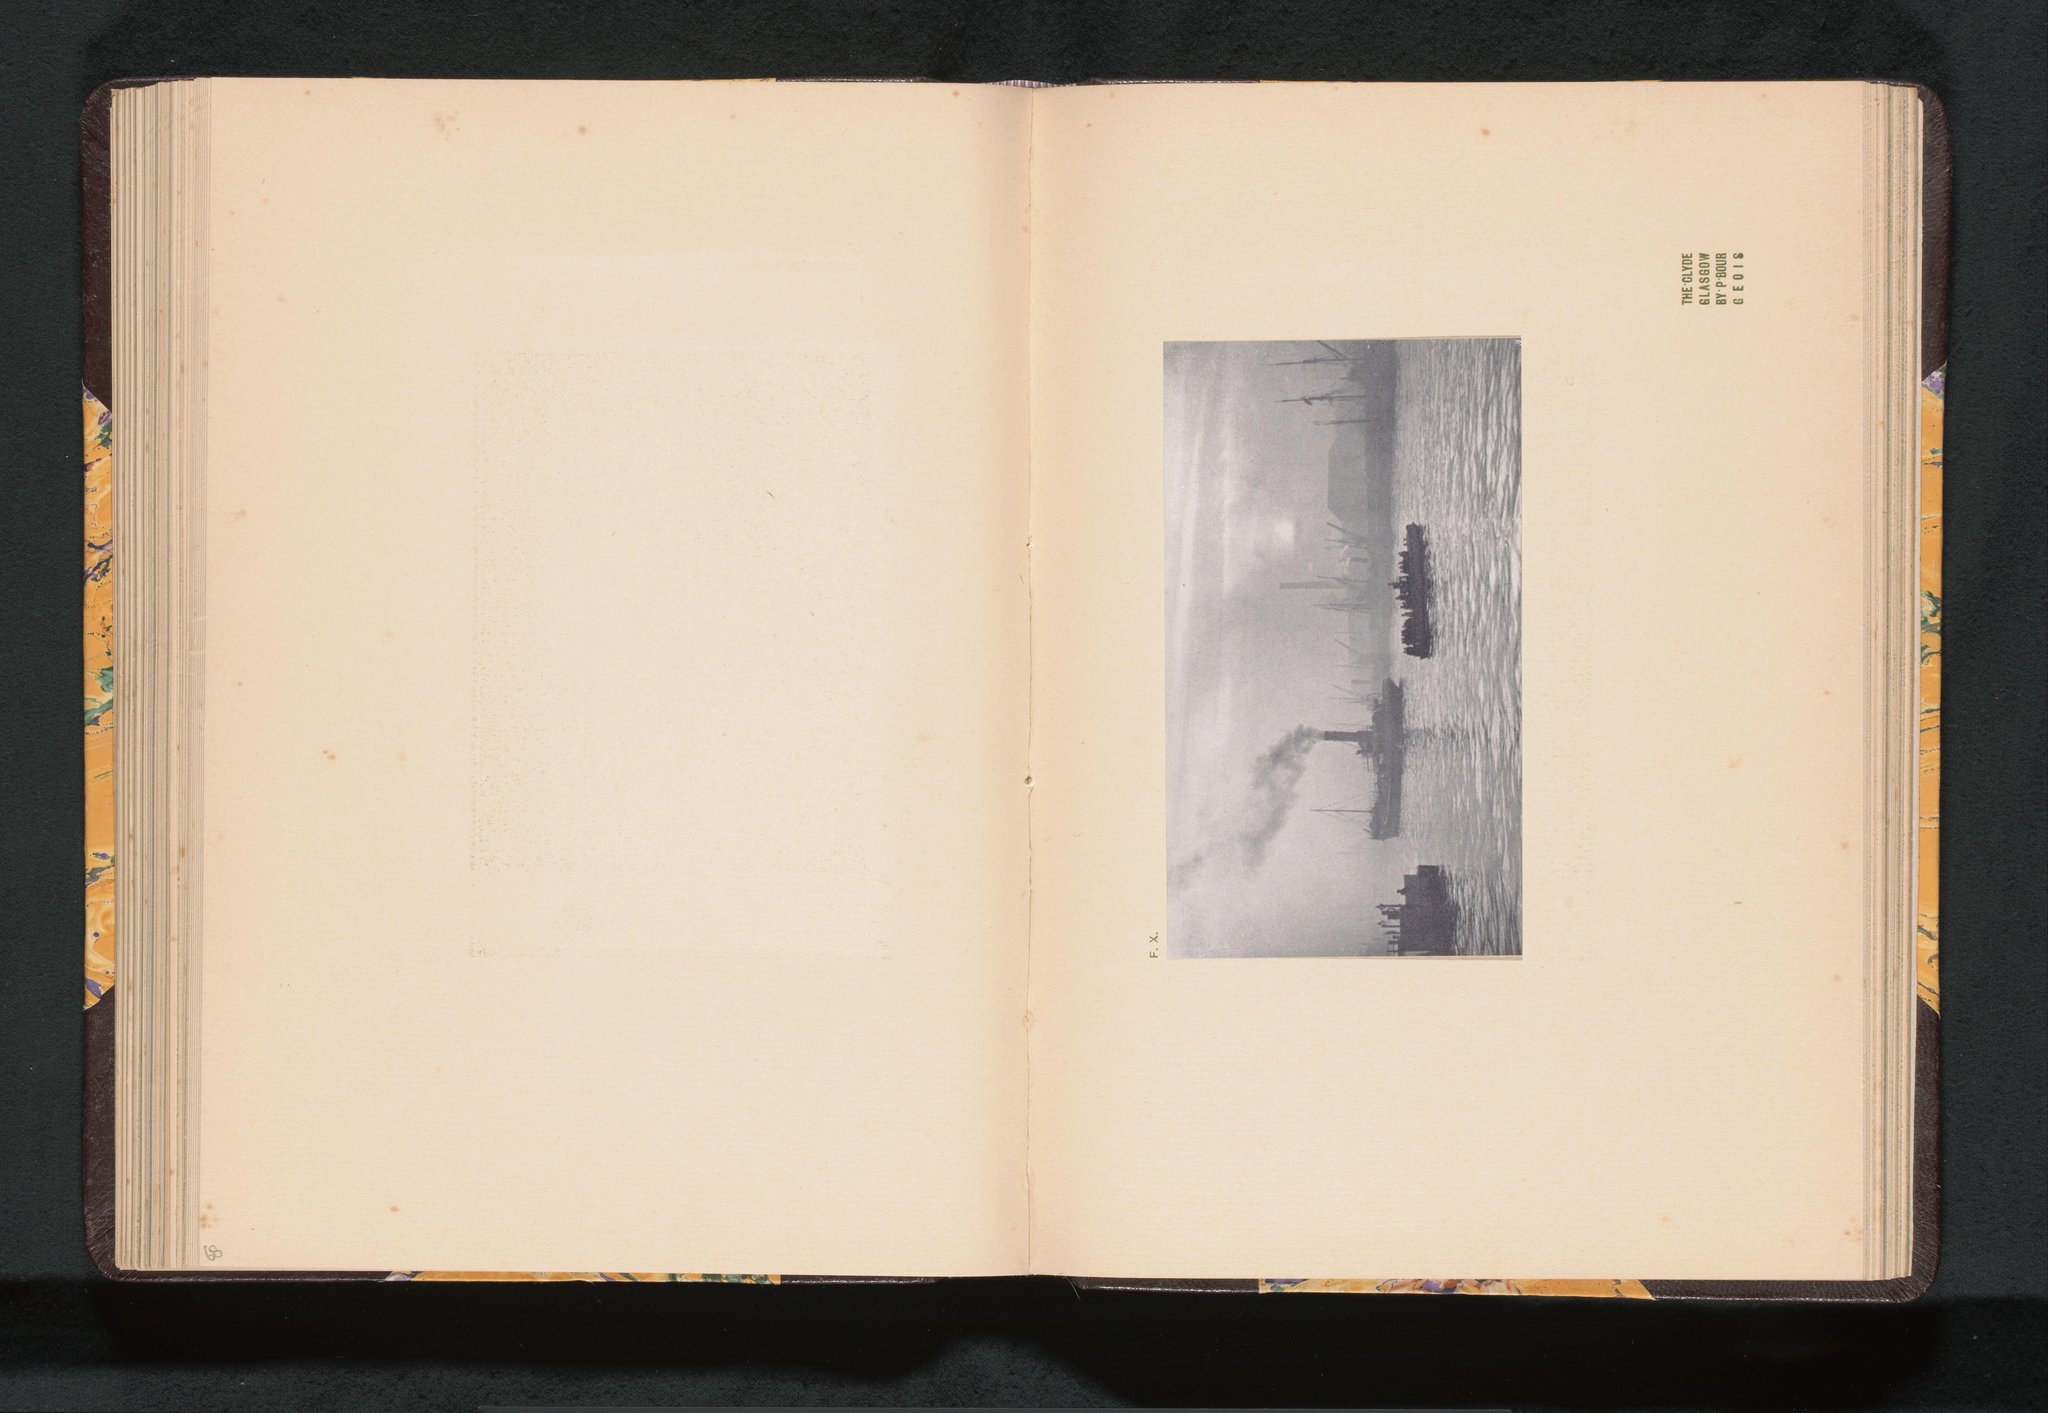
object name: page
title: Gezicht op de Clyde nabij Glasgow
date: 1900-1905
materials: paper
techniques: autotype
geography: glasgow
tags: river, ships (in general)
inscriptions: inscription: ‘F. X.’, inscription: ‘The clyde by P. Bourgeois’, monogram: ‘AG’